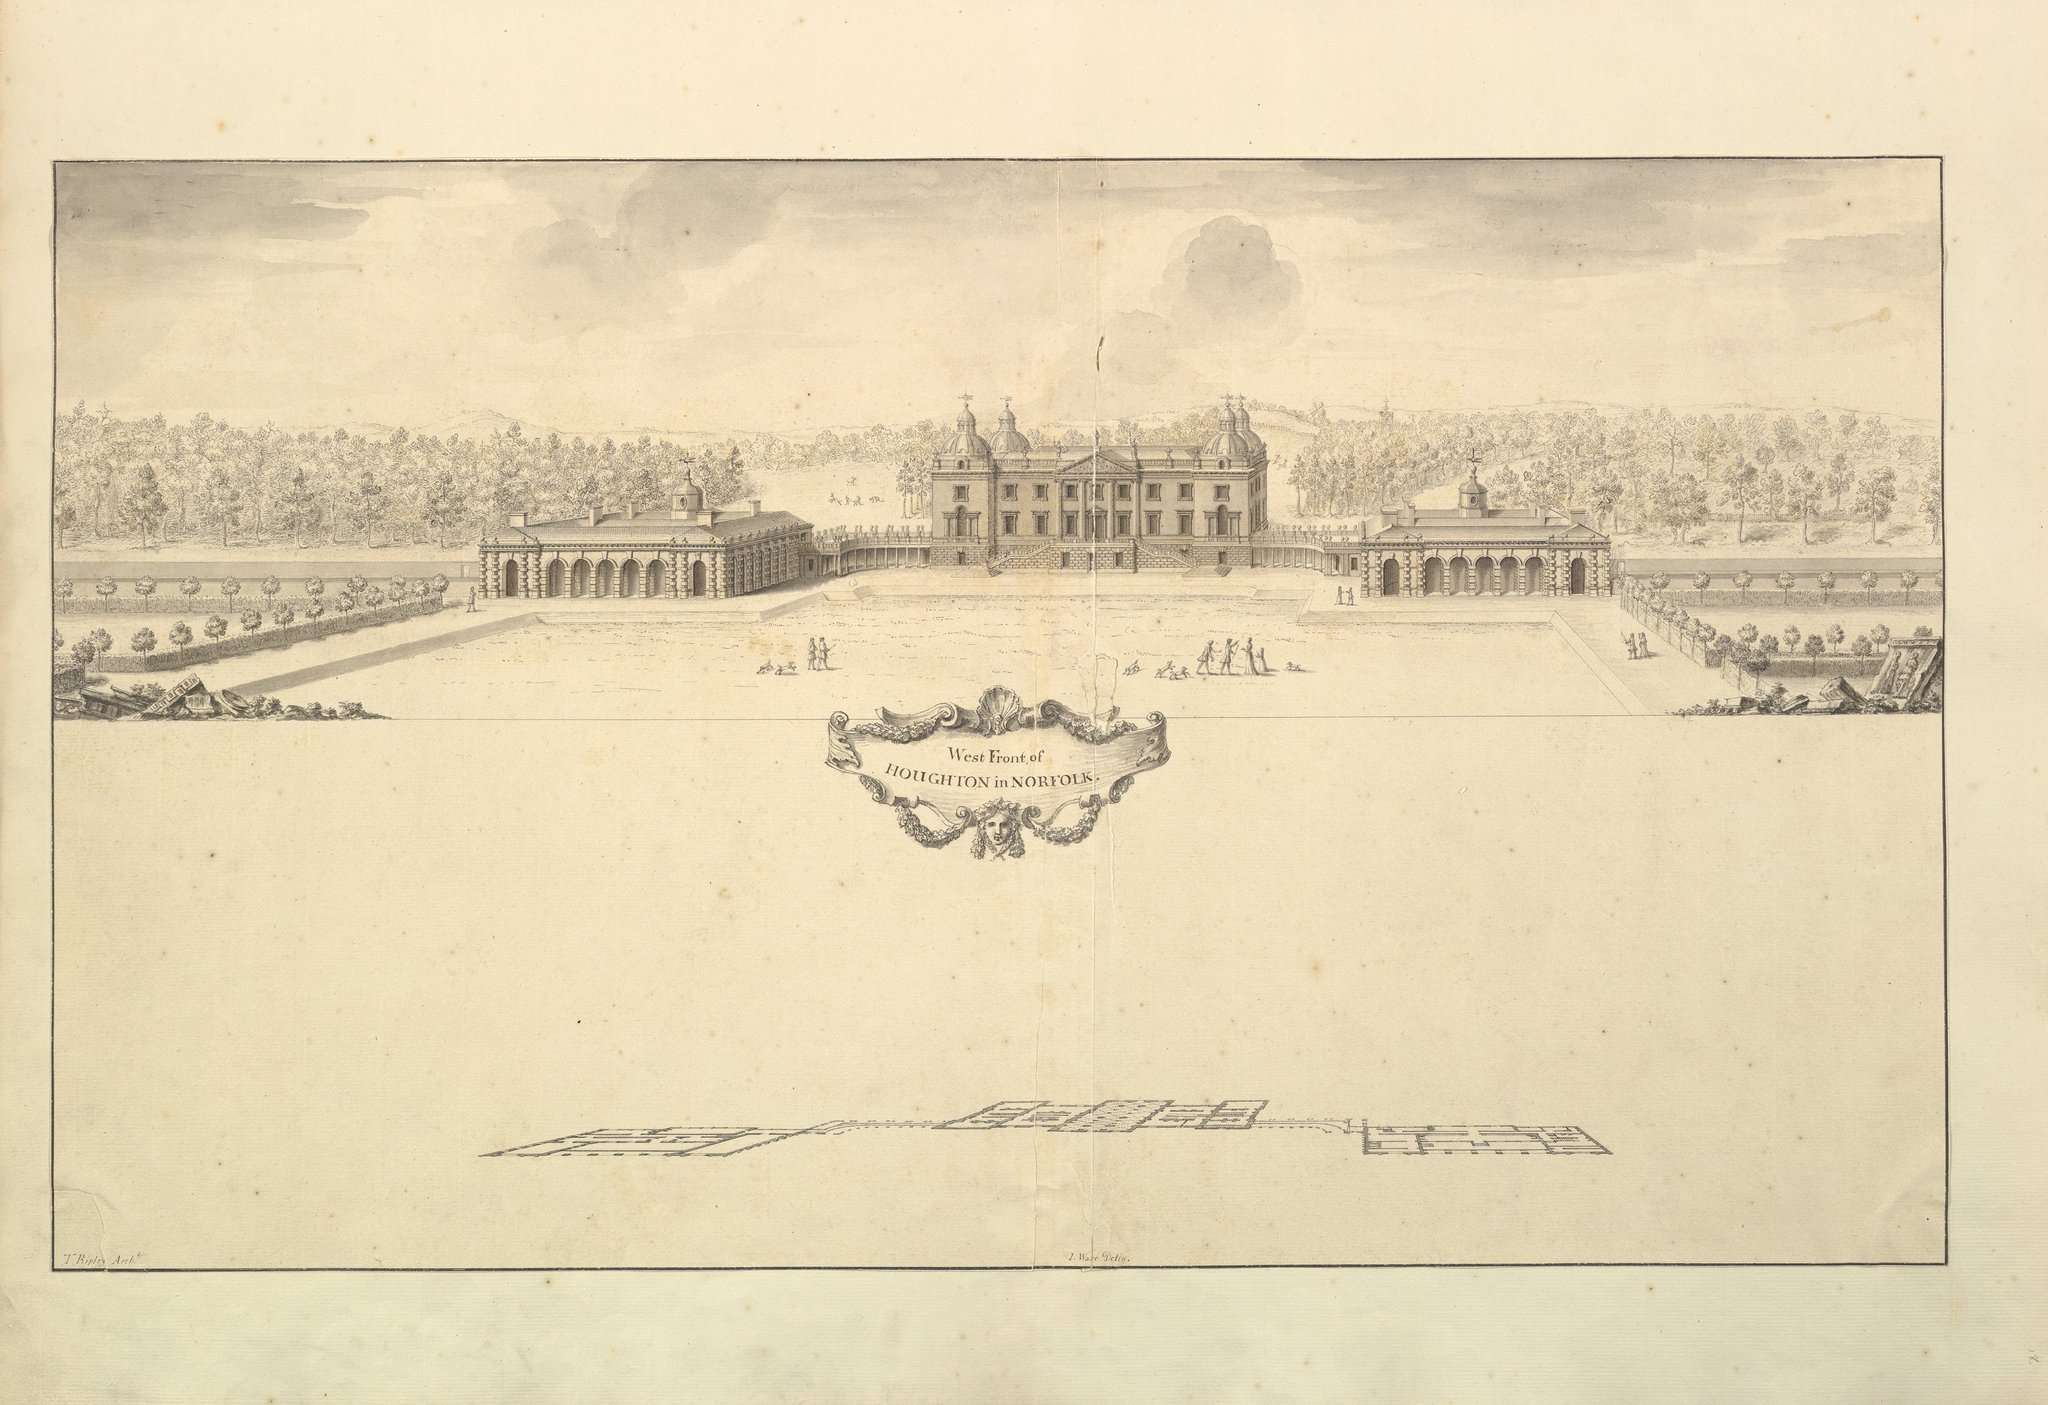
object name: drawing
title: West Front of Houghton Hall in Norfolk, Perspective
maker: thomas ripley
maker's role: artist and architect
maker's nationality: british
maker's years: 1683-1758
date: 1735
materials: ink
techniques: brush, pen, wash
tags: human figures,buildings,parks,faces,dogs,landscapes,trees